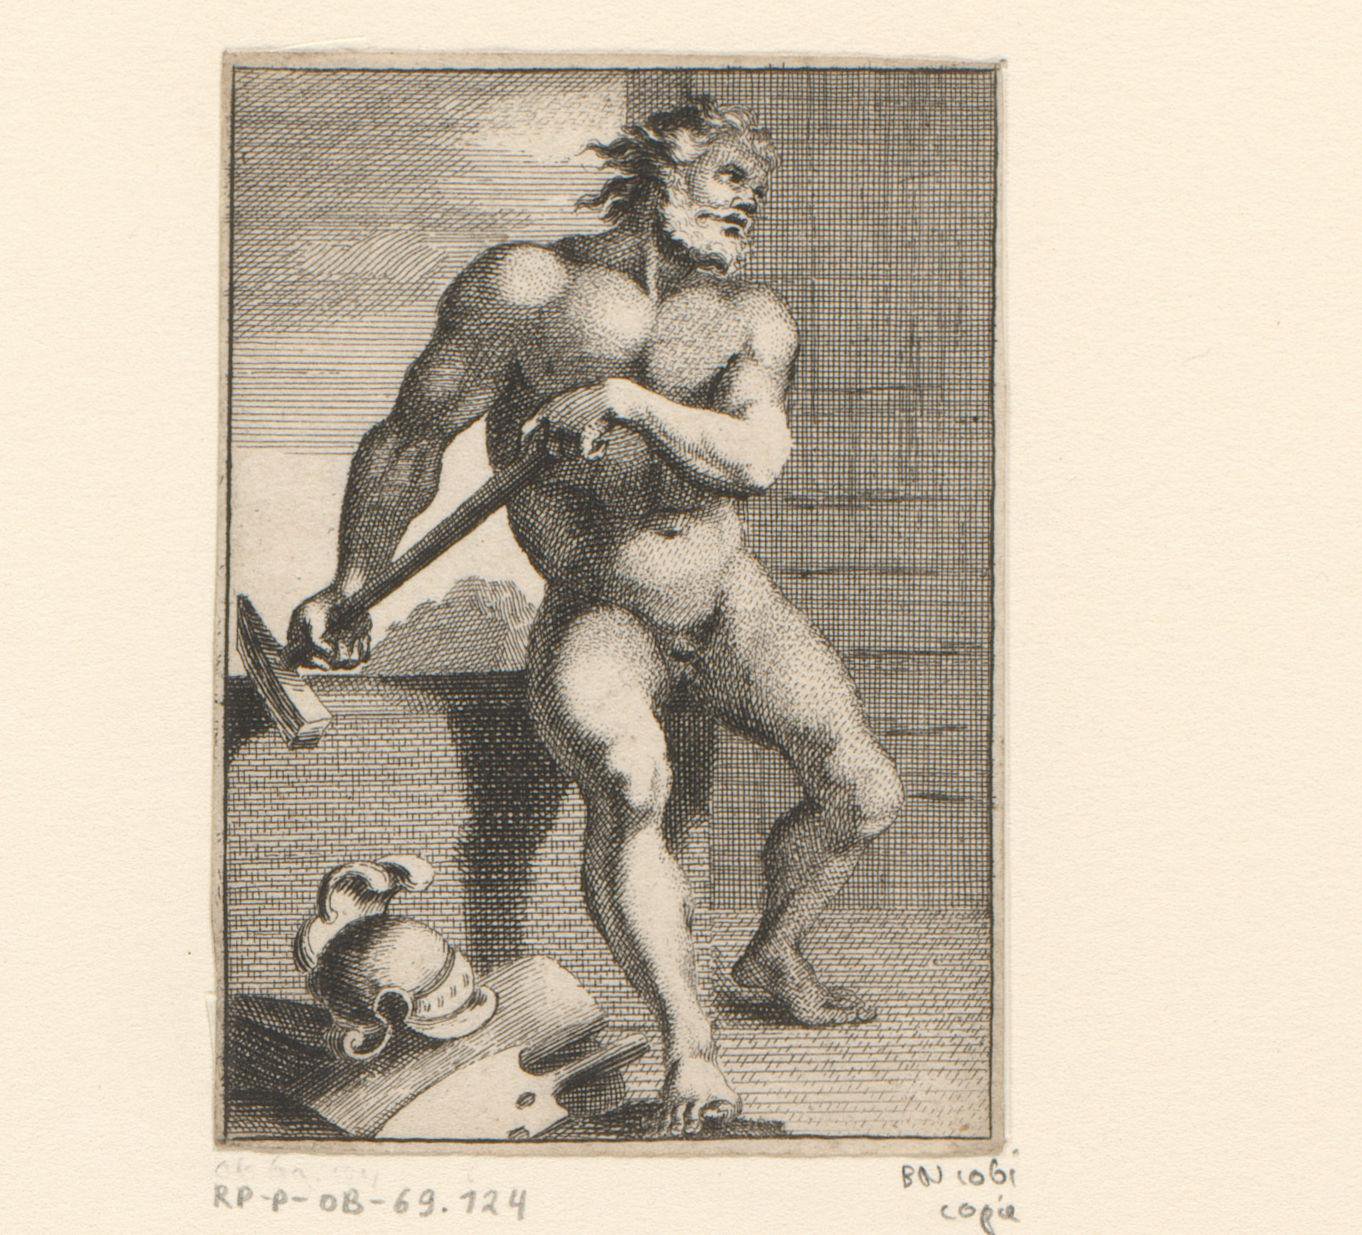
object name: print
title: Vulcanus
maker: Anonymous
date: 1647-1714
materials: paper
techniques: engraving, etching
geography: france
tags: (story of) vulcan (hephaestus)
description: Deze prent is een anonieme kopie naar de originele prent van Sébastien Leclerc.